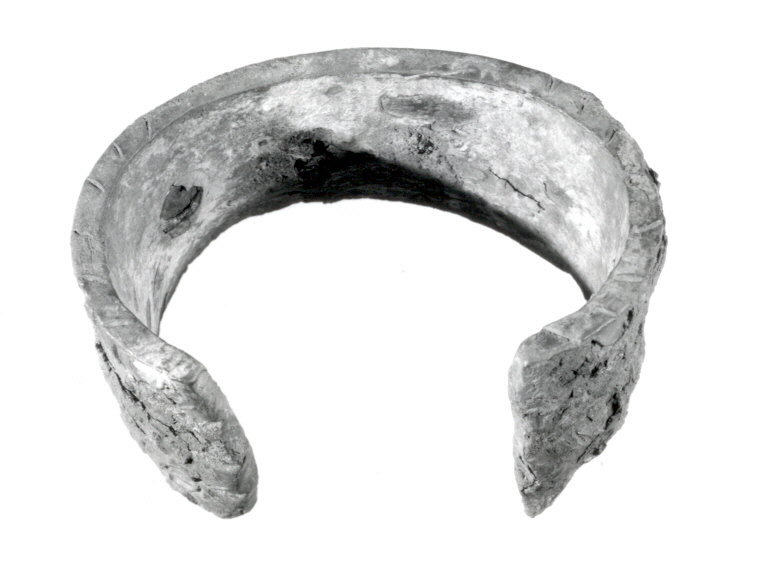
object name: bracelet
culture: iranian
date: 800-601 BCE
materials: iron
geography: iran, probably from luristan